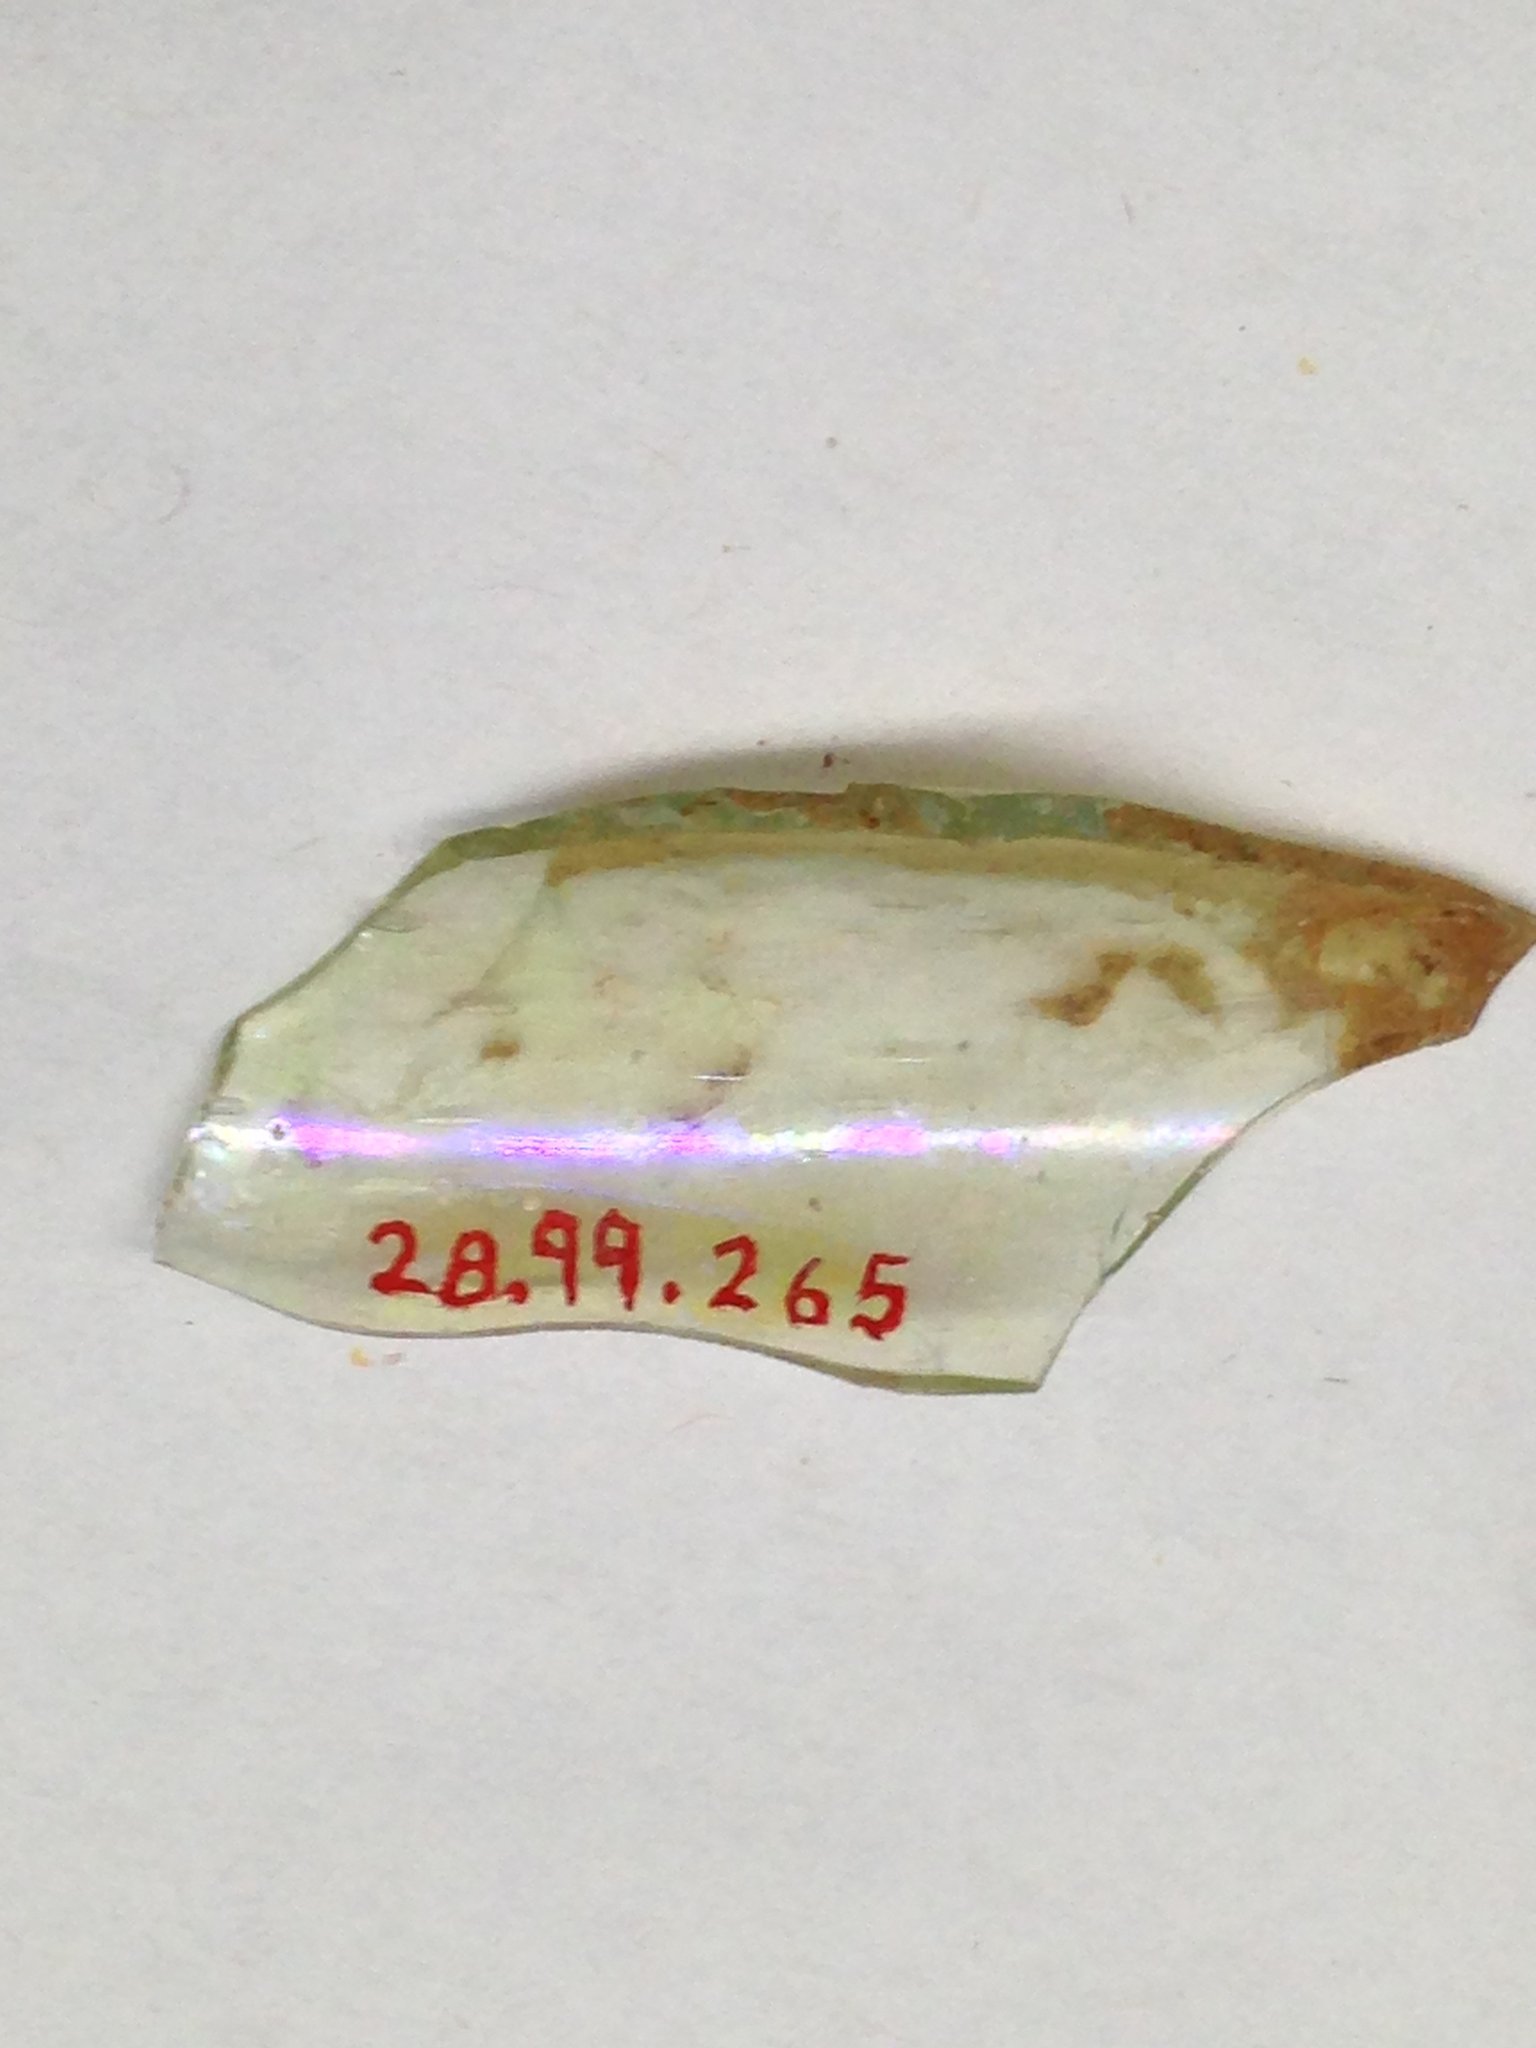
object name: fragment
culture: european or middle eastern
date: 1150-1250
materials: ceramic, glass